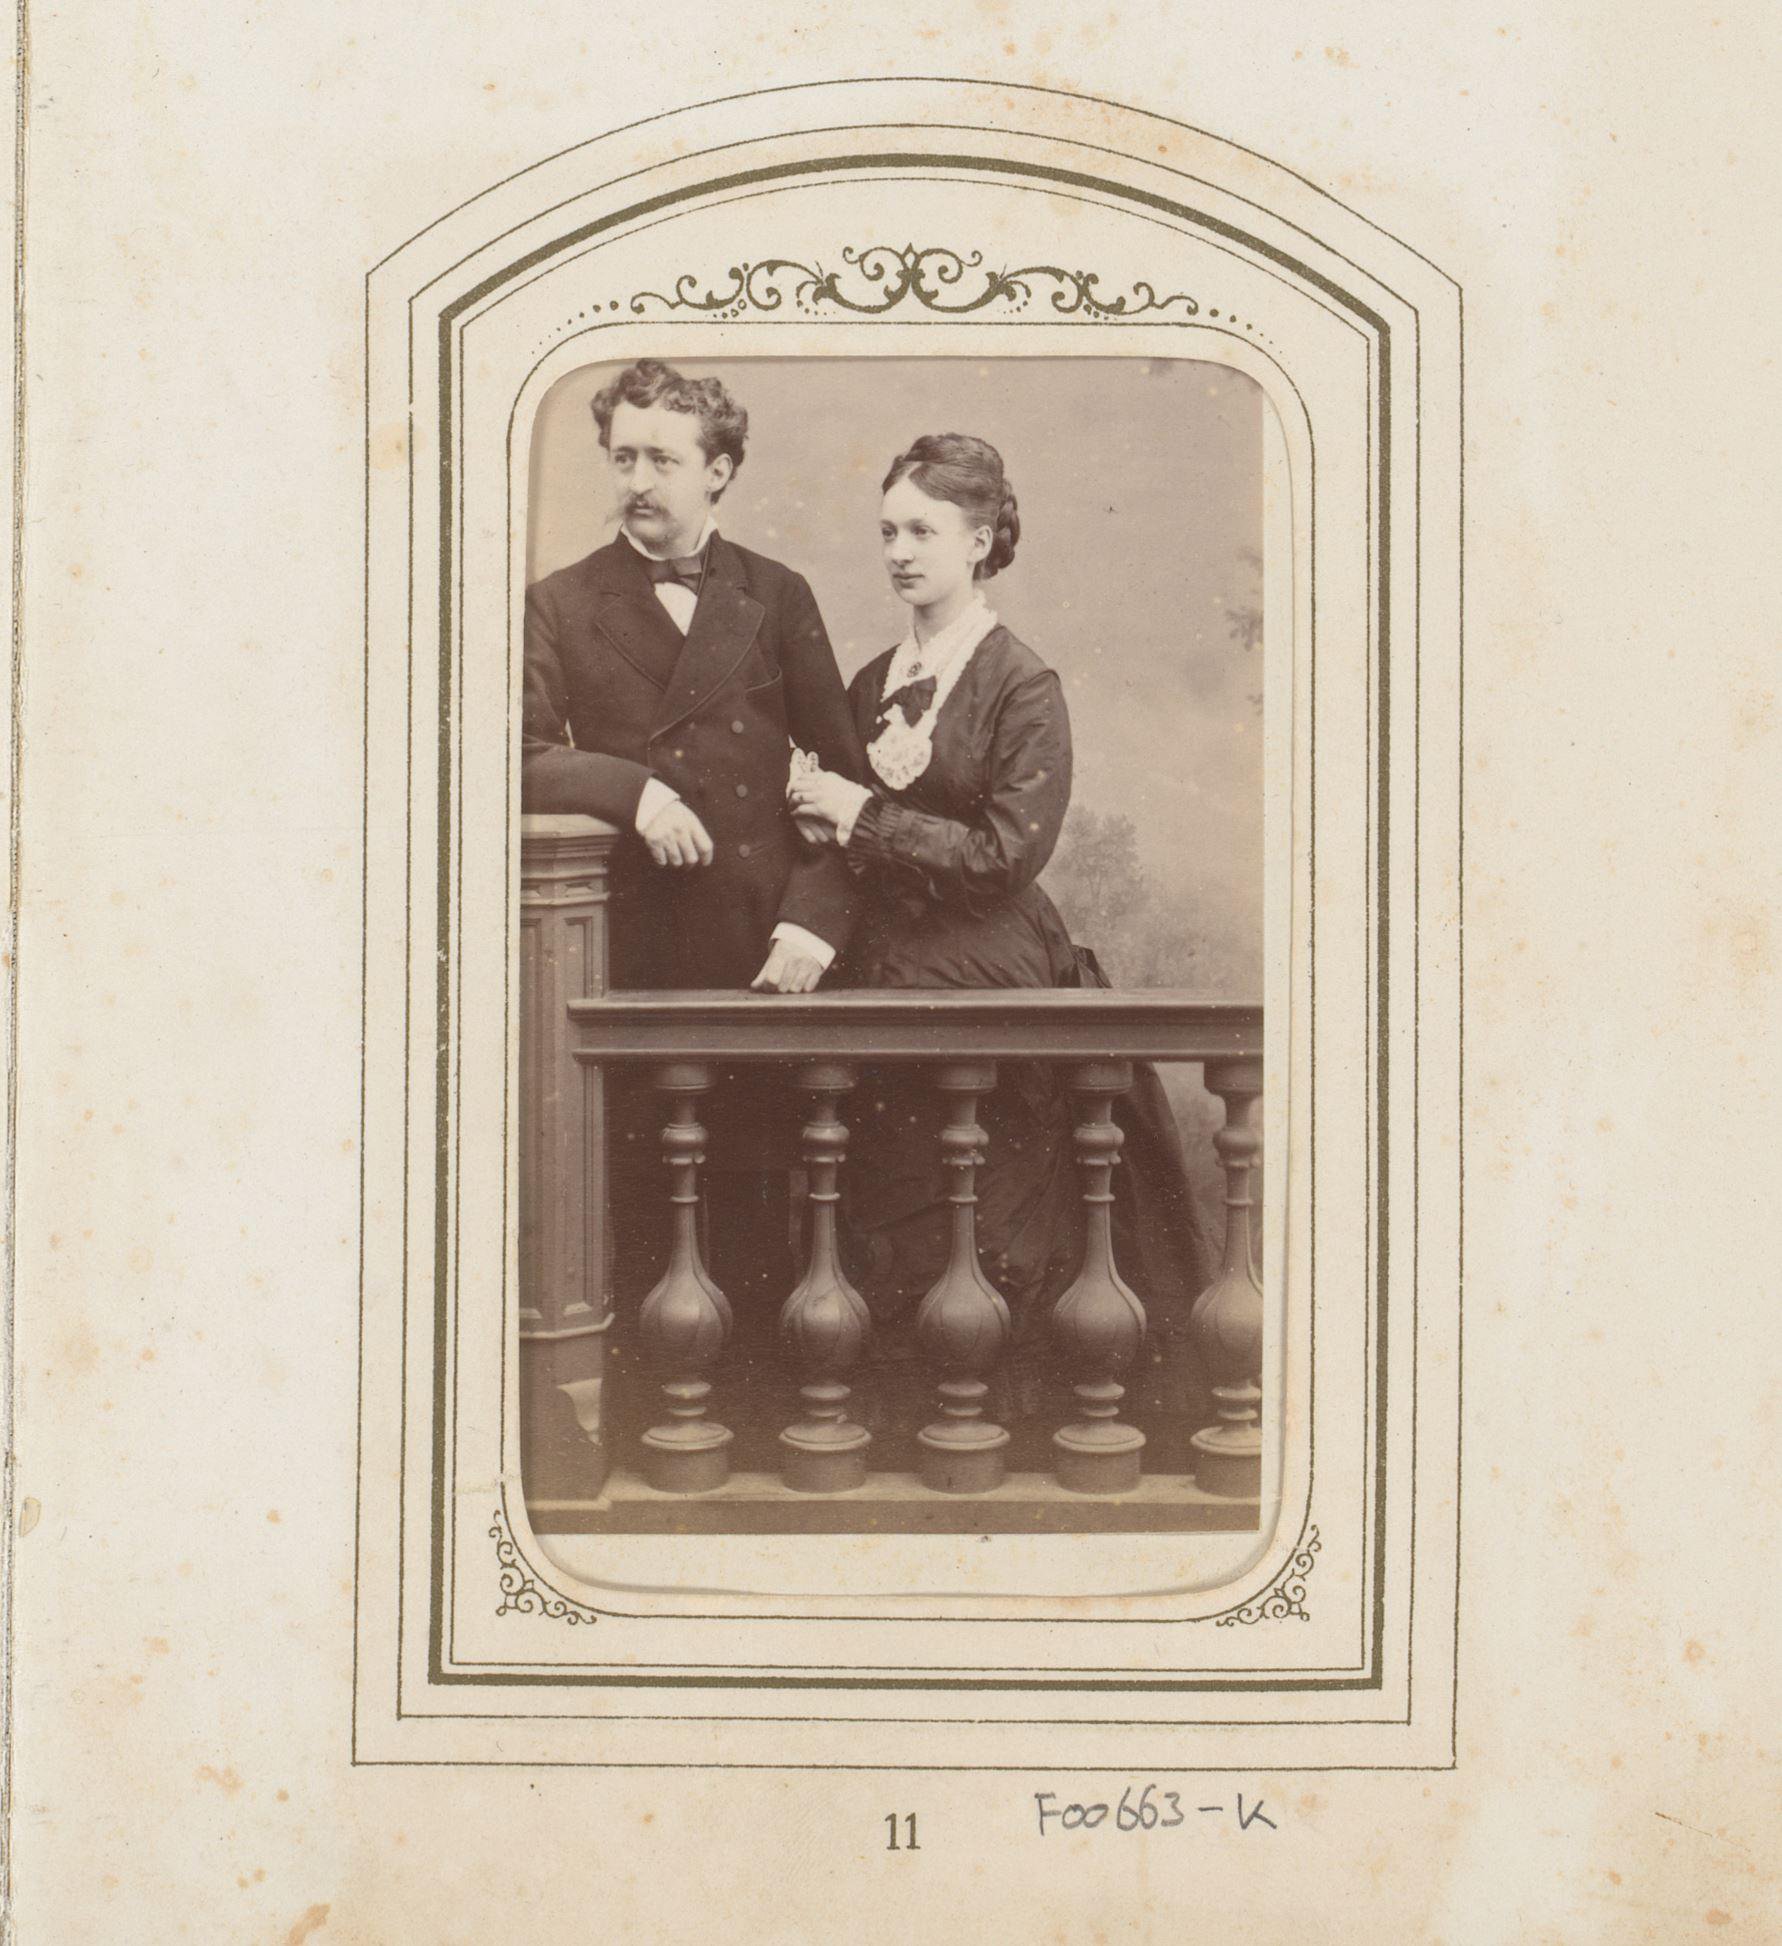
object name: photograph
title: Portret van een echtpaar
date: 1860-1880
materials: cardboard, photographic support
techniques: albumen print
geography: the hague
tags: historical persons - bb - woman, historical persons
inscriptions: number: ‘11’, inscription: ‘De Lavieter & Co./ Photographes/ Willemstraat No. 2/ La Haye’